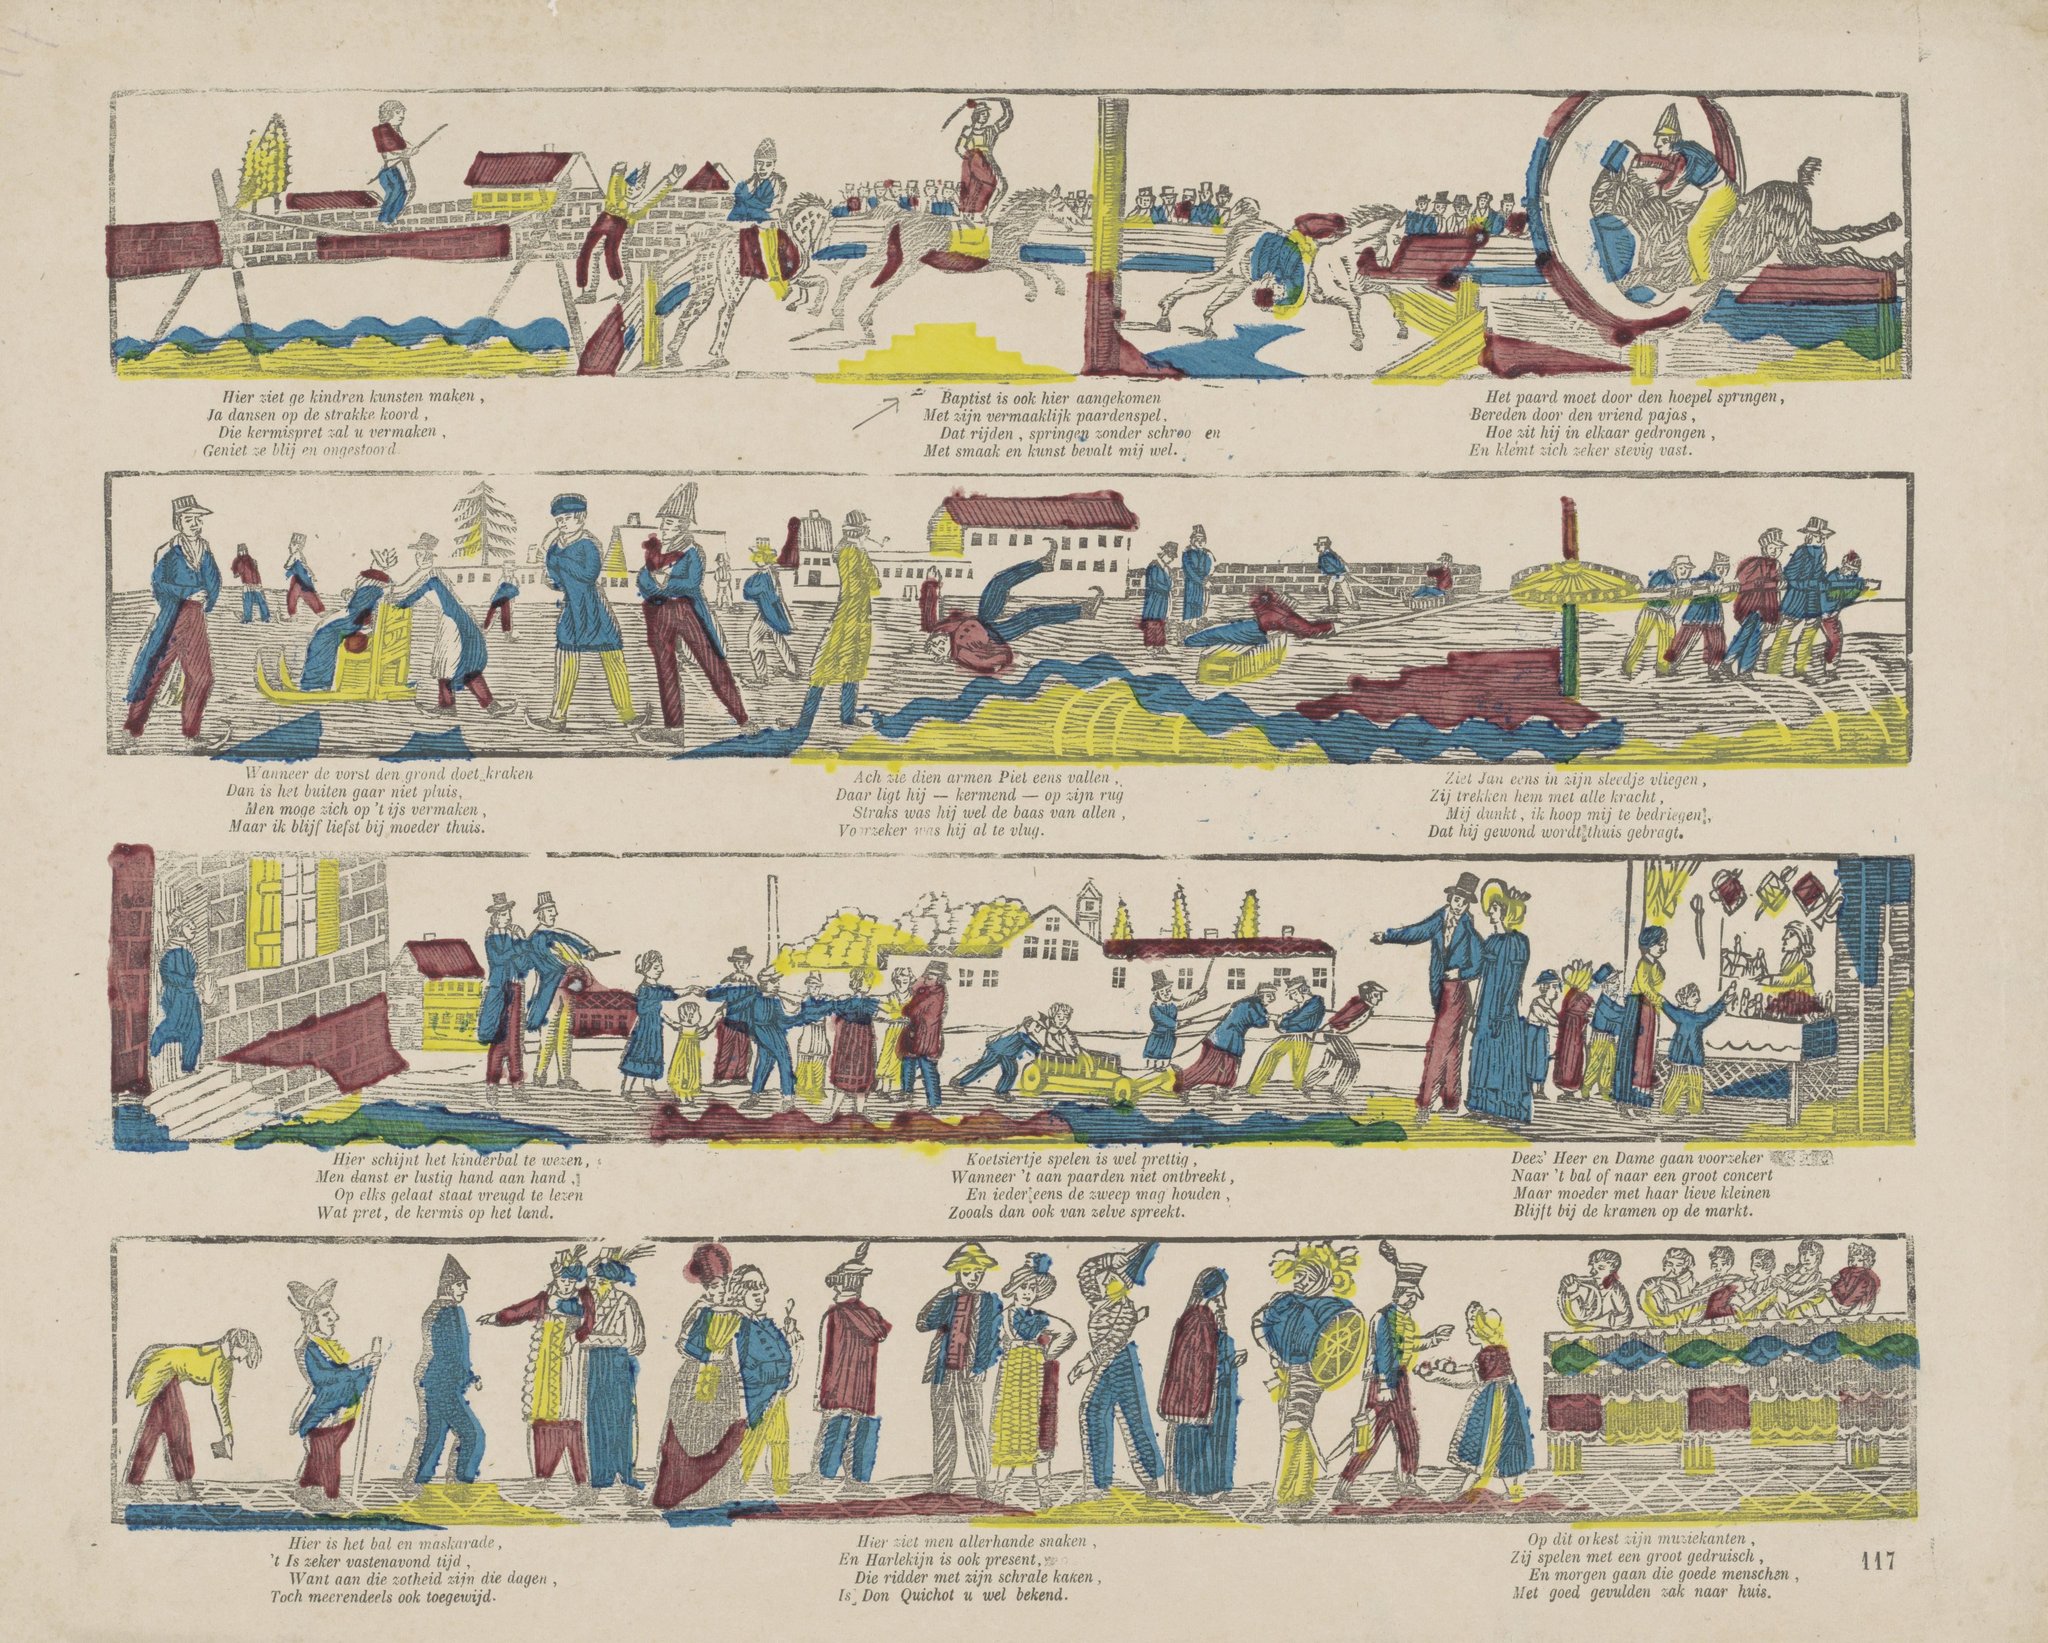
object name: popular print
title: Verschillende voorstellingen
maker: Anonymous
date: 1848-1881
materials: paper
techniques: colour, letterpress printing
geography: netherlands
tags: children's games and plays, dancing, skates (winter sports), masquerade, masked ball, the show; fair and circus performers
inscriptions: collector's mark: Lugt 2760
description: Blad met 4 voorstellingen van circusartiesten, ijsvermaak, dansende en spelende kinderen en van een gemaskerd bal. Onder elke voorstelling een twaalfregelig vers in drie kolommen. Genummerd rechtsonder: 117.